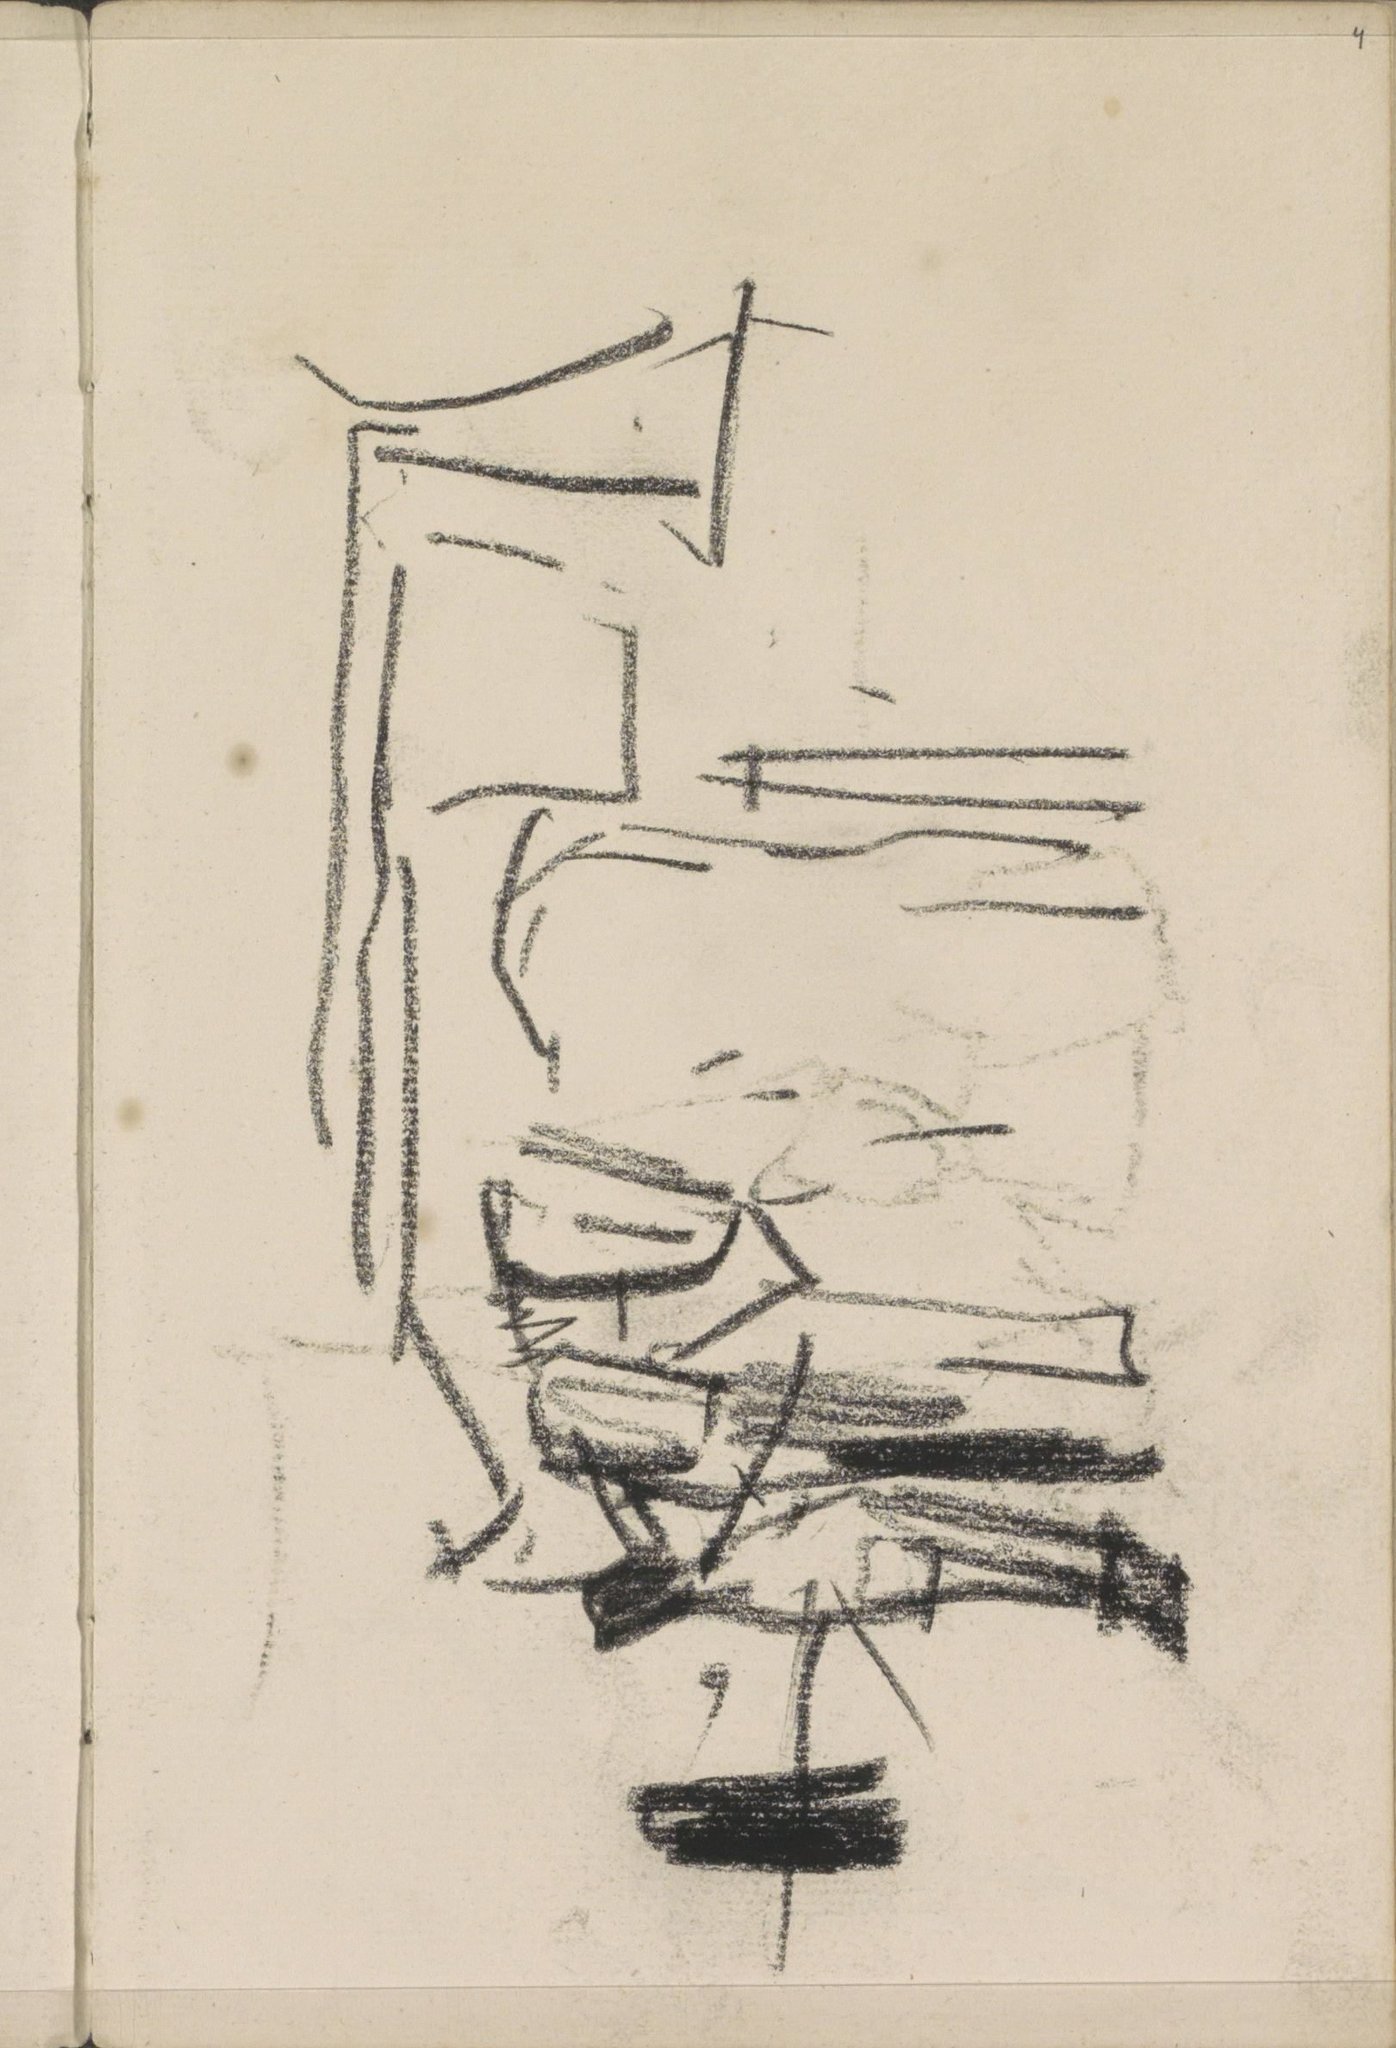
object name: sketchbook leaf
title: Man bij paarden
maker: george hendrik breitner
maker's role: draughtsman, painter, print maker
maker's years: 1857-1923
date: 1883-1885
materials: chalk, paper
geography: the hague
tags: adult man, horse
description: Pagina 4 uit een schetsboek met 18 bladen.